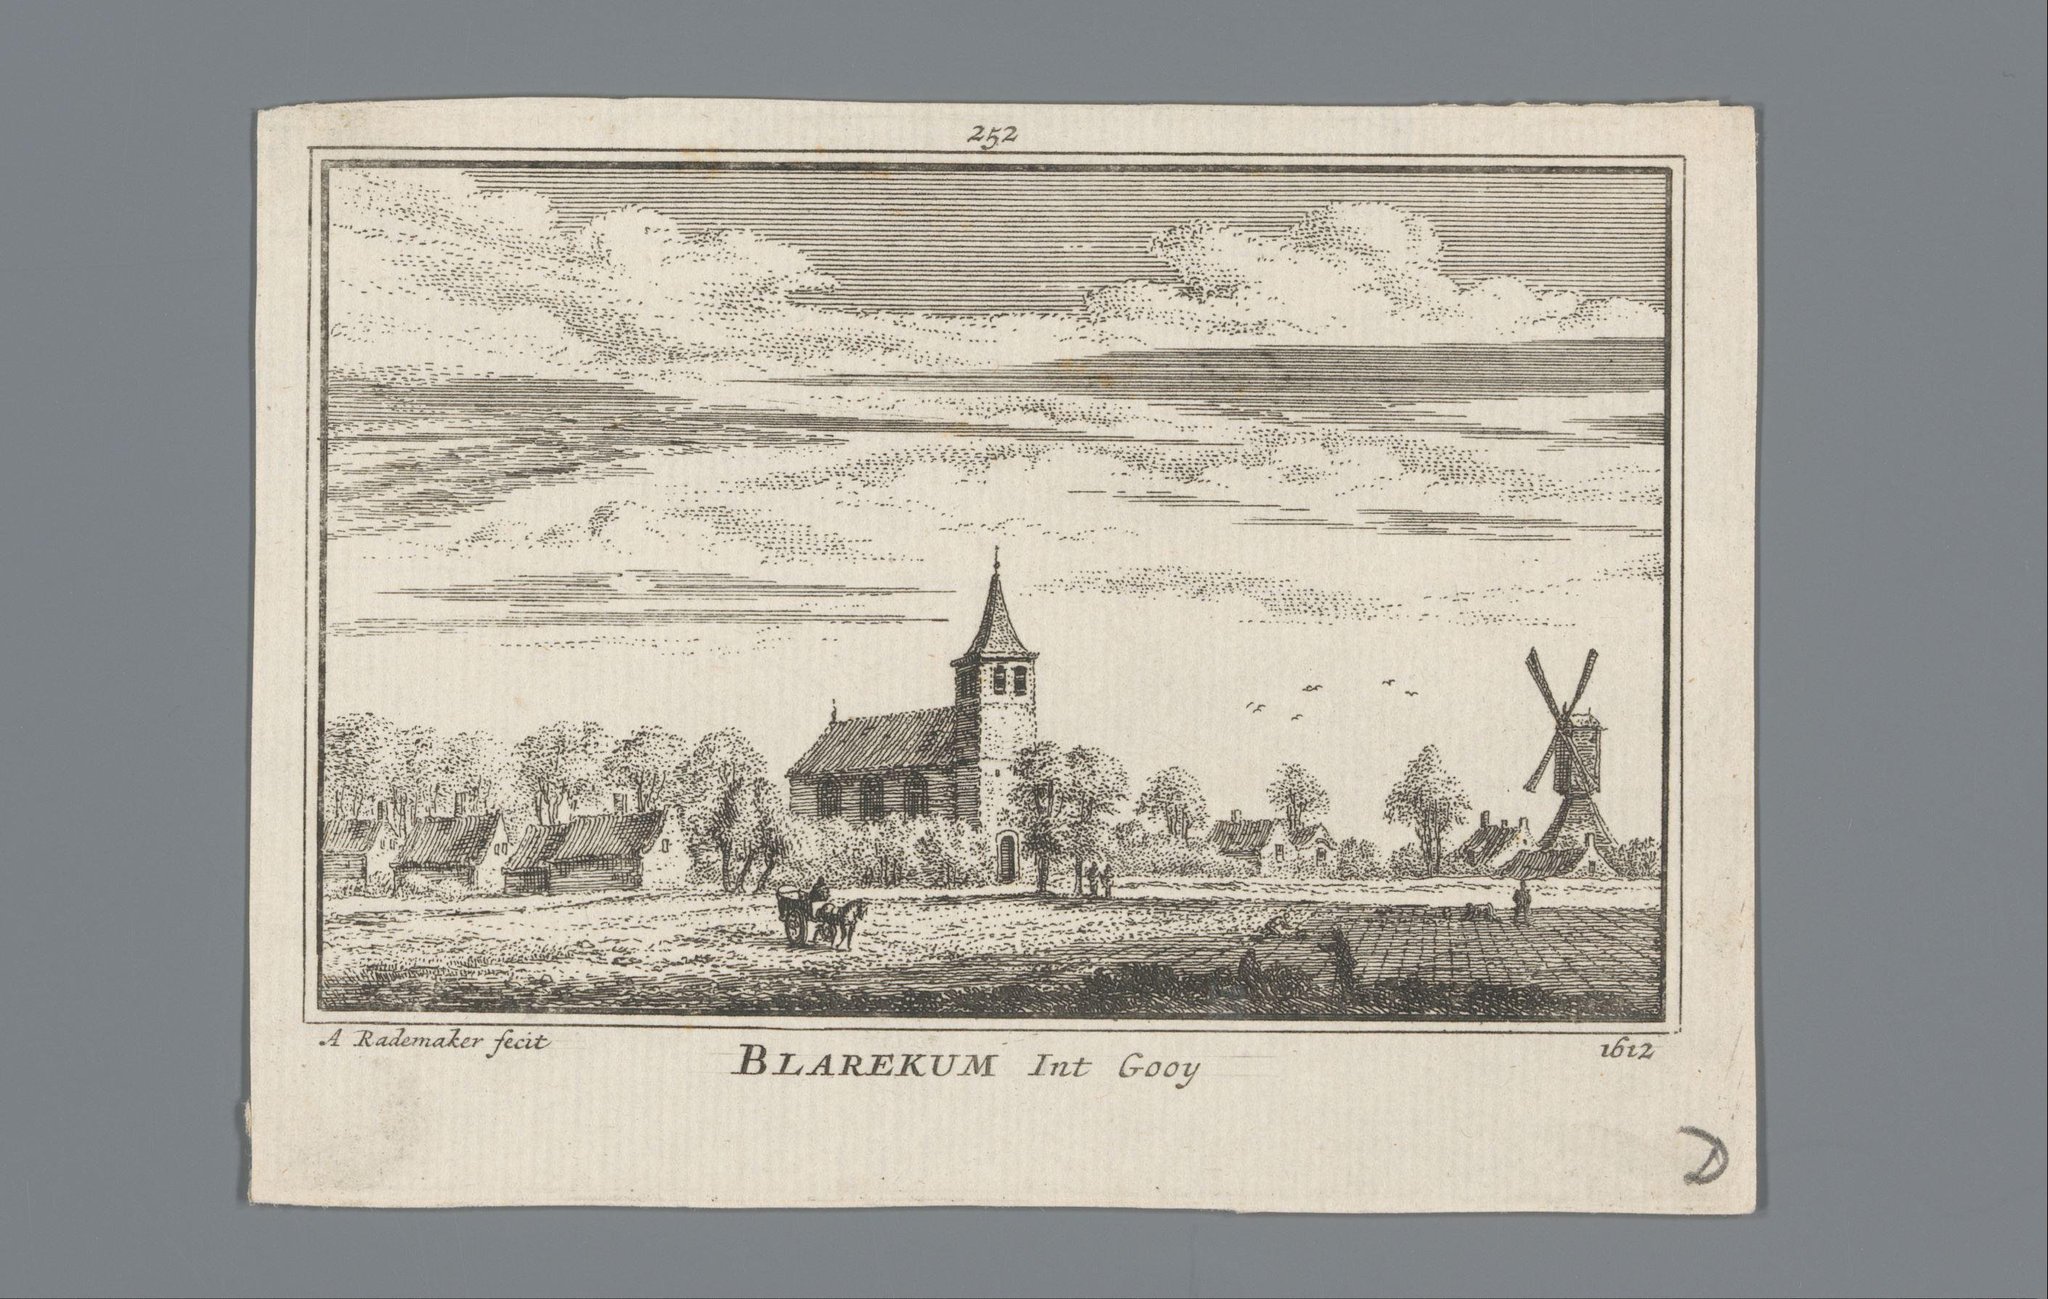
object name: book illustration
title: Blarekum int Gooy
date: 1727-1733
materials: paper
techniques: etching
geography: amsterdam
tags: prospect of village, silhouette of village, church (exterior), agriculture, windmill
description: Prent uit: Rademaker, Abraham, Niedek, Matthaeus Brouërius van, Long, Isaac Le. Kabinet van Nederlandsche en Kleefsche outheden en (...) voorname stads- en landgebouwen. Amsterdam: Willem Barents en Antoni Schoonenburg, 1727-1733, ill. nr. 252.